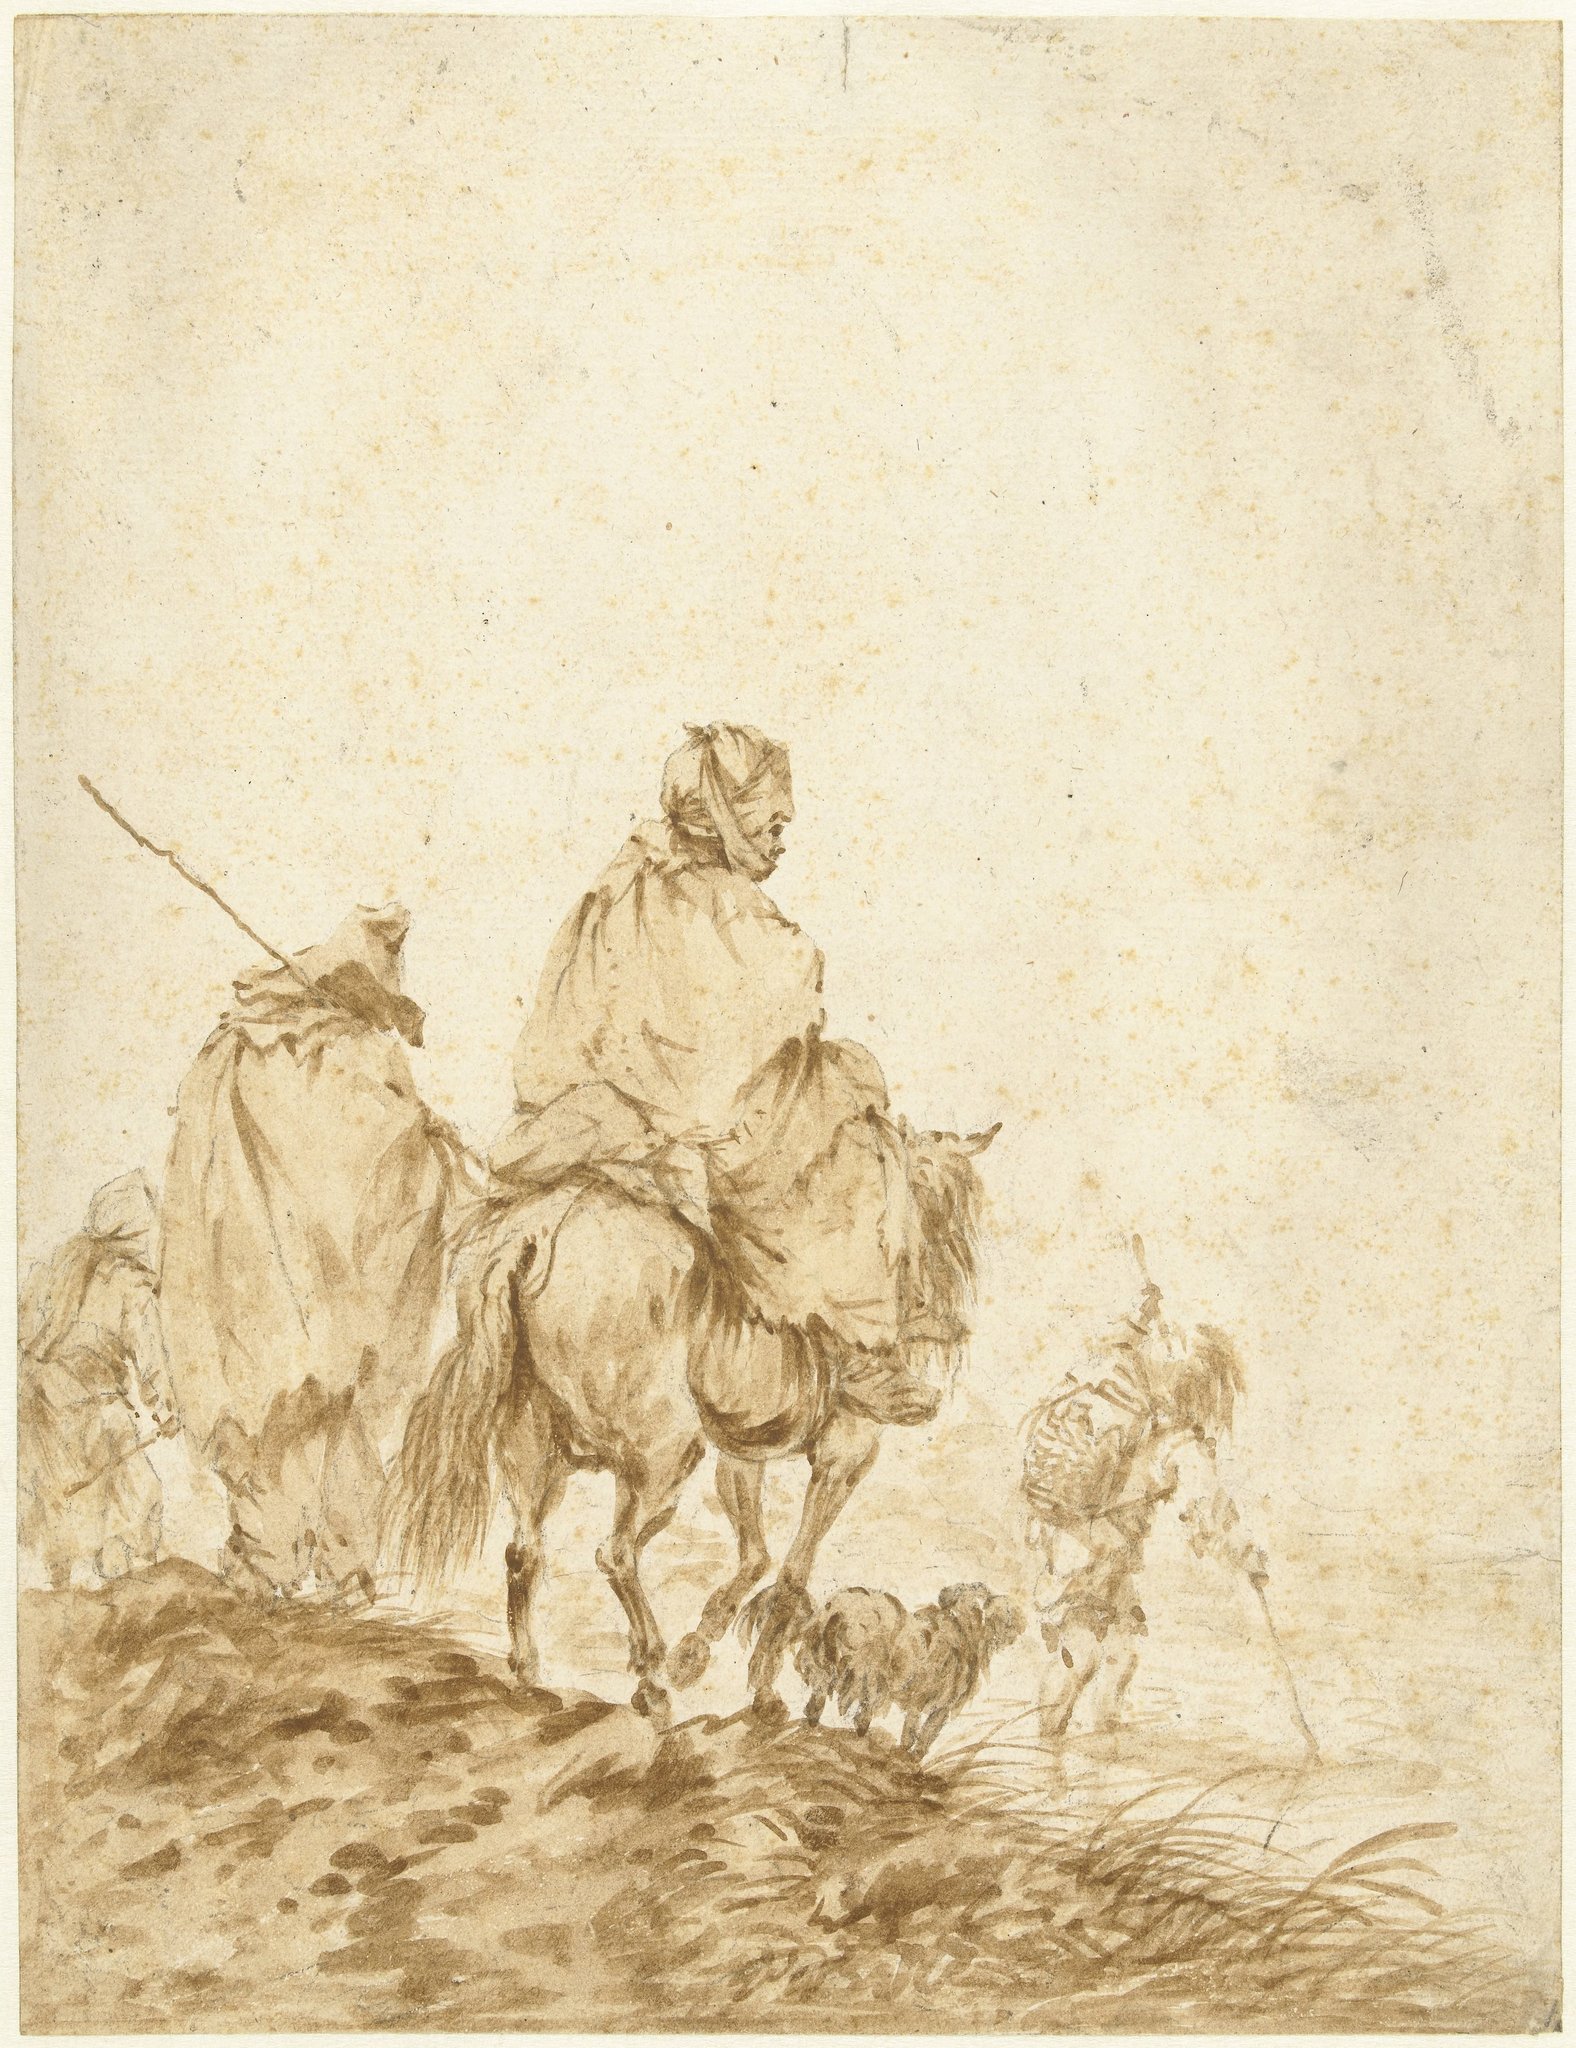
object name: drawing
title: Schamel geklede reizigers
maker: francesco giuseppe casanova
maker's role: draughtsman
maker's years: 1727-1802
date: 1737-1802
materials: paper, pencil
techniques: brush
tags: stadia of travel